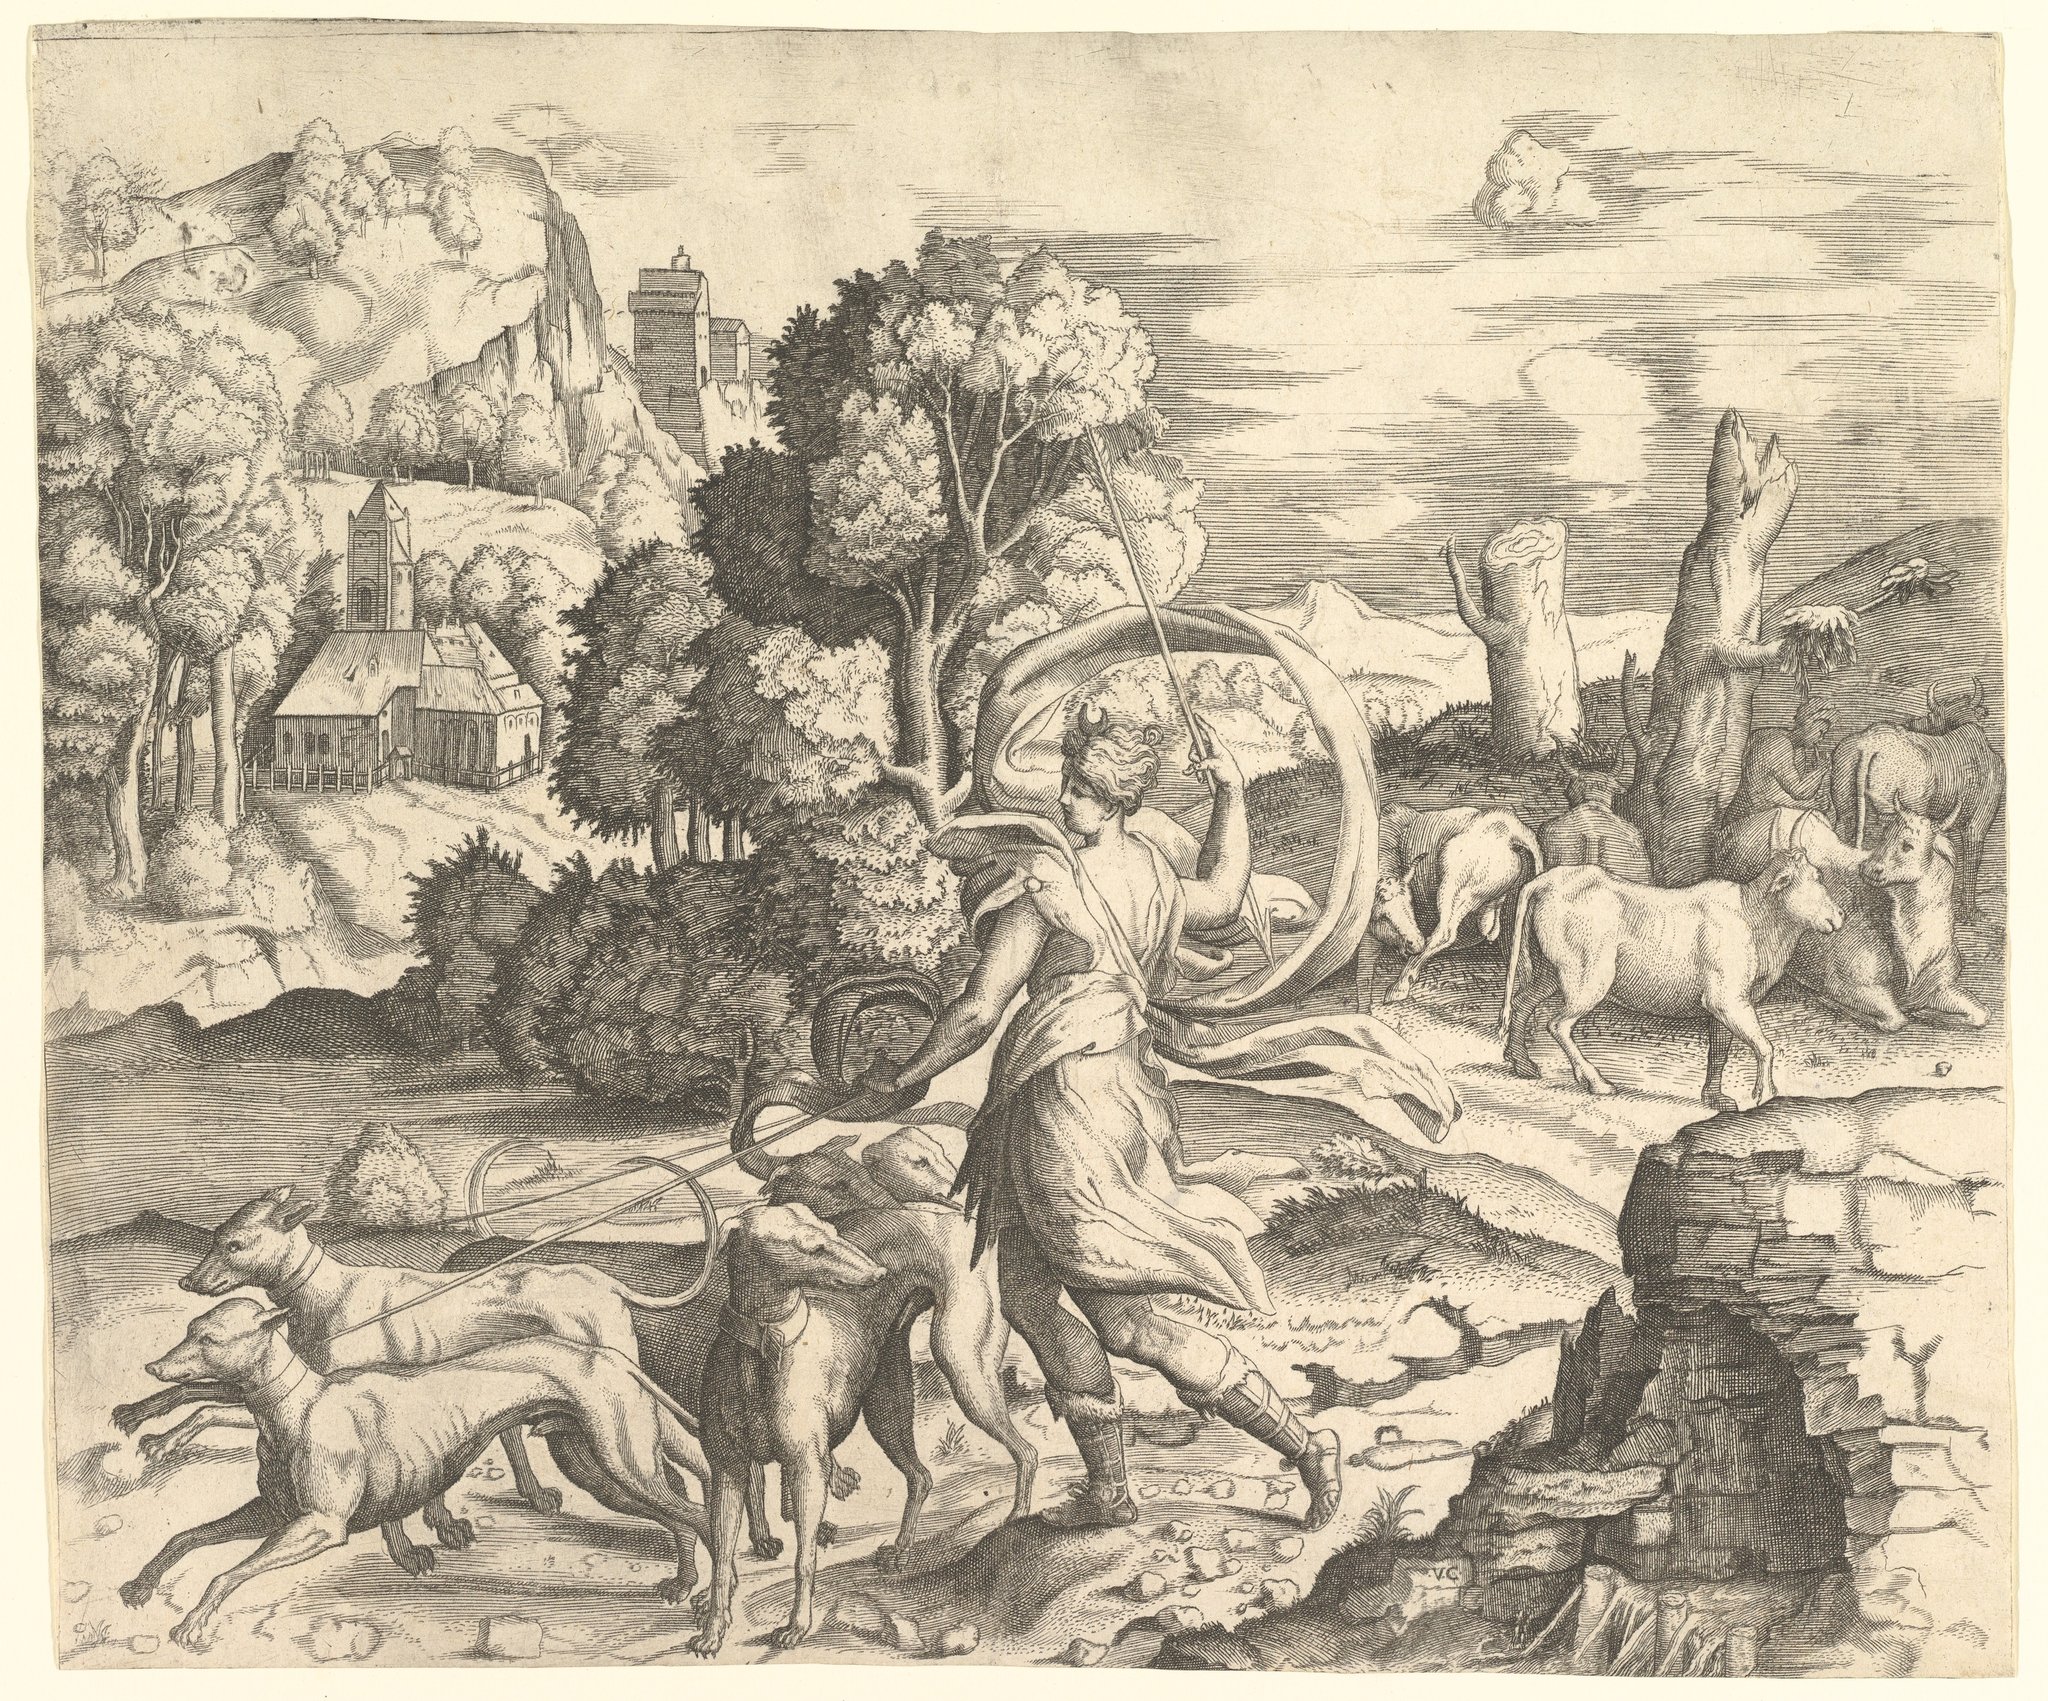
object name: print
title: Diana the Huntress in a Landscape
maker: vincenzo caccianemici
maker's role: artist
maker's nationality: italian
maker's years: -1542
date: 1530-1542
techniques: engraving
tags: diana,cows,dogs,trees